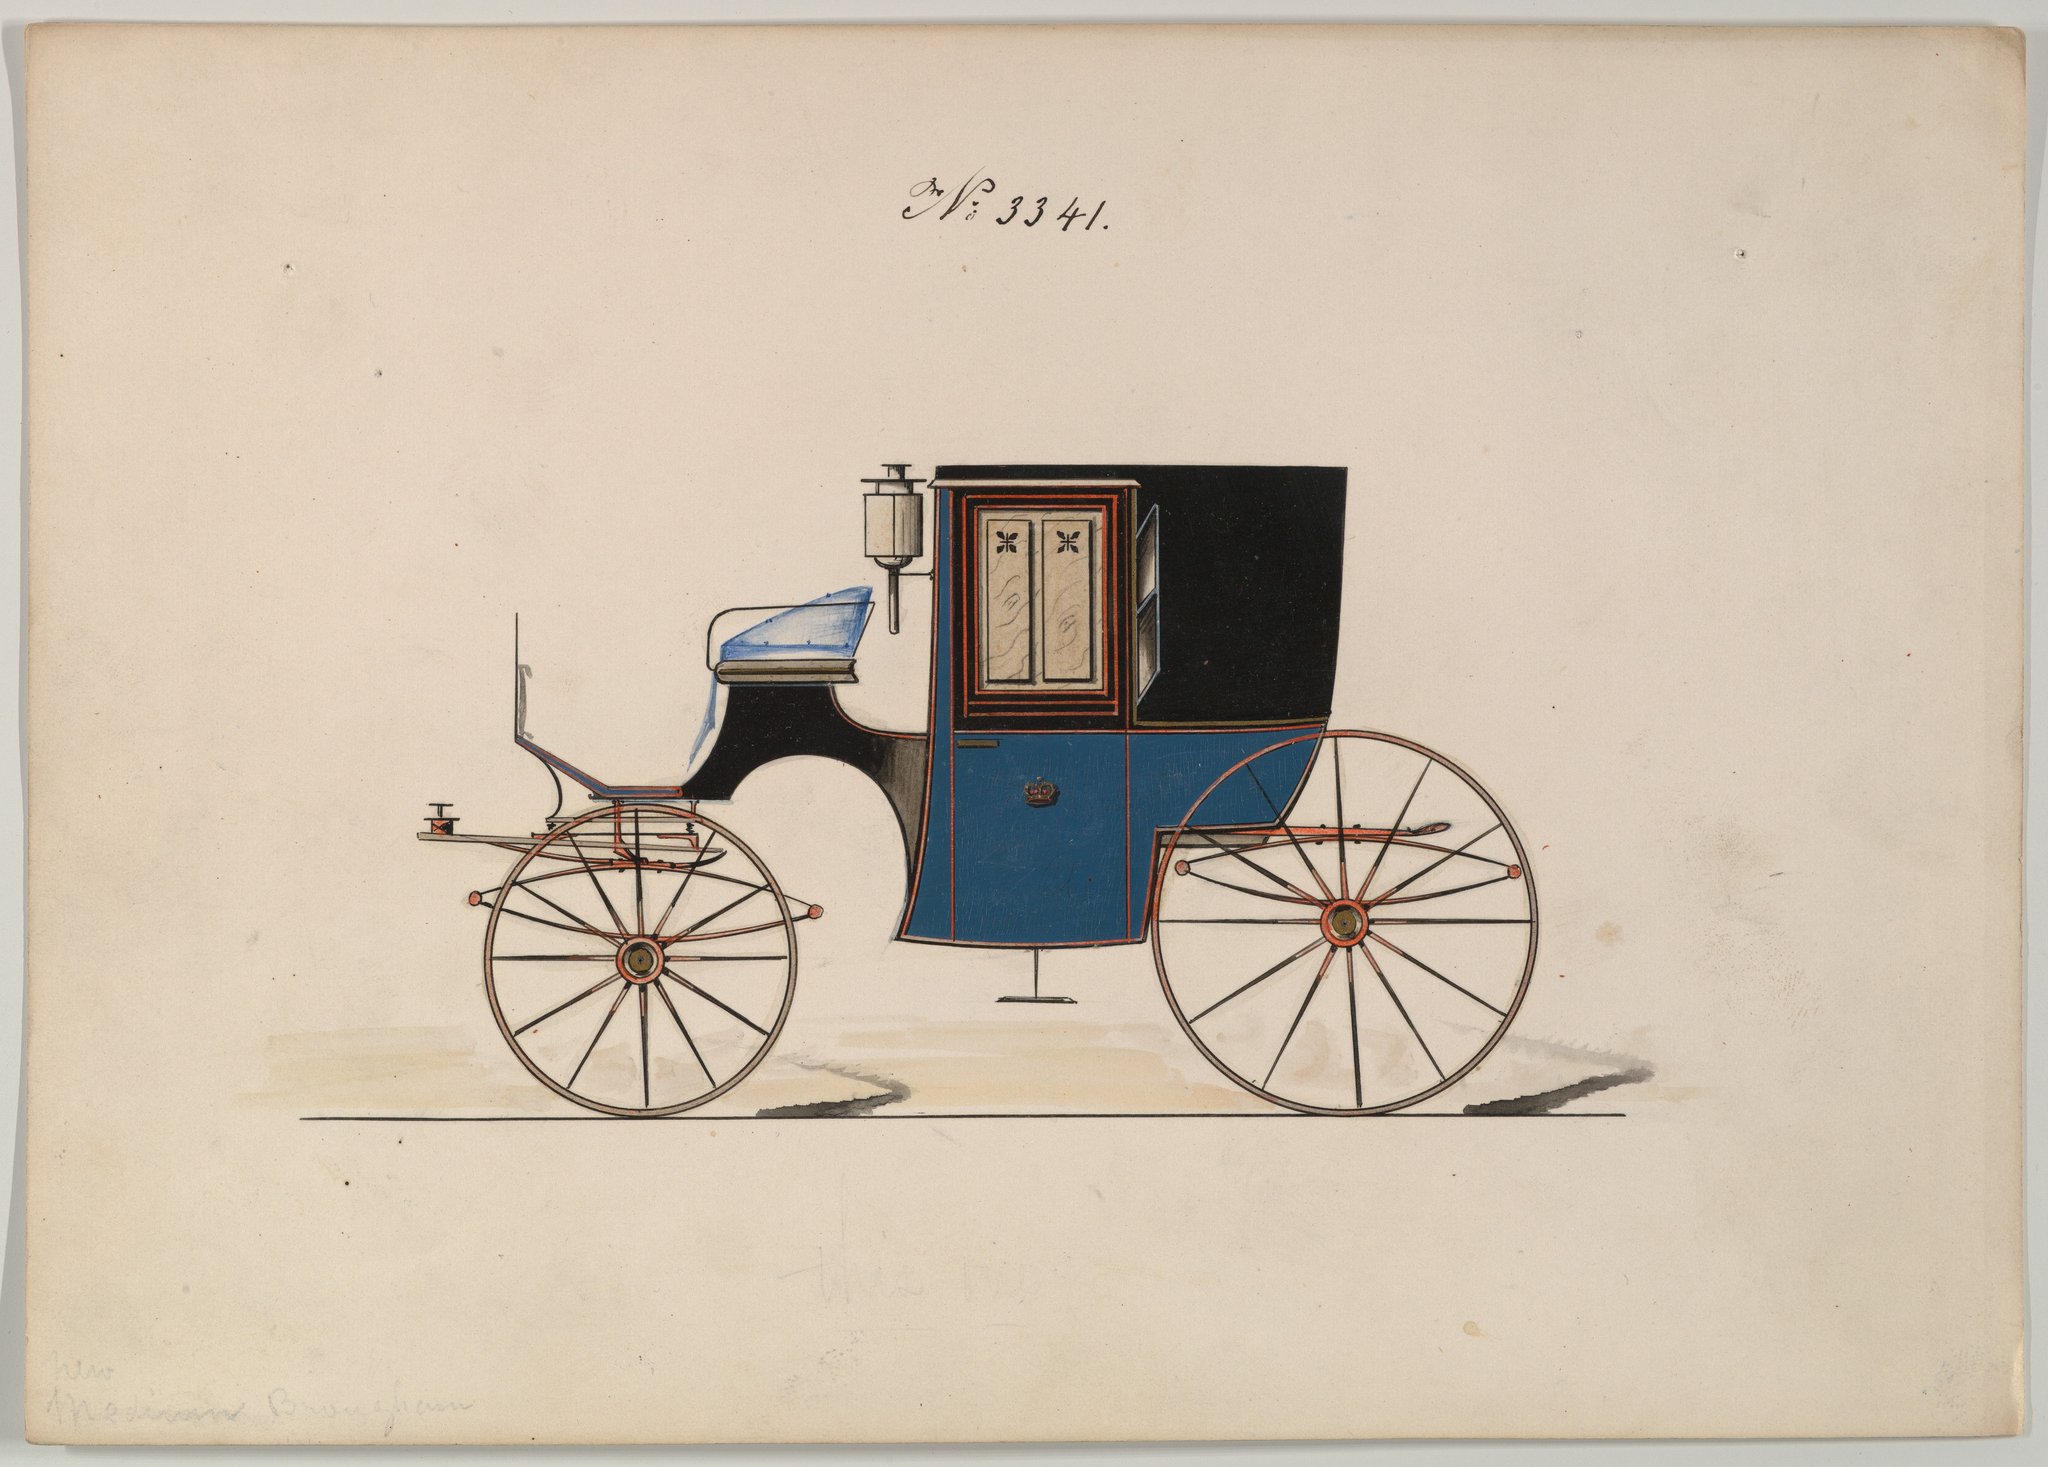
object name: drawing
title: Brougham #3341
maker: brewster & co.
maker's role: manufacturer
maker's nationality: american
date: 1877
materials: gouache, gum arabic, ink, watercolor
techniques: pen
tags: carriages